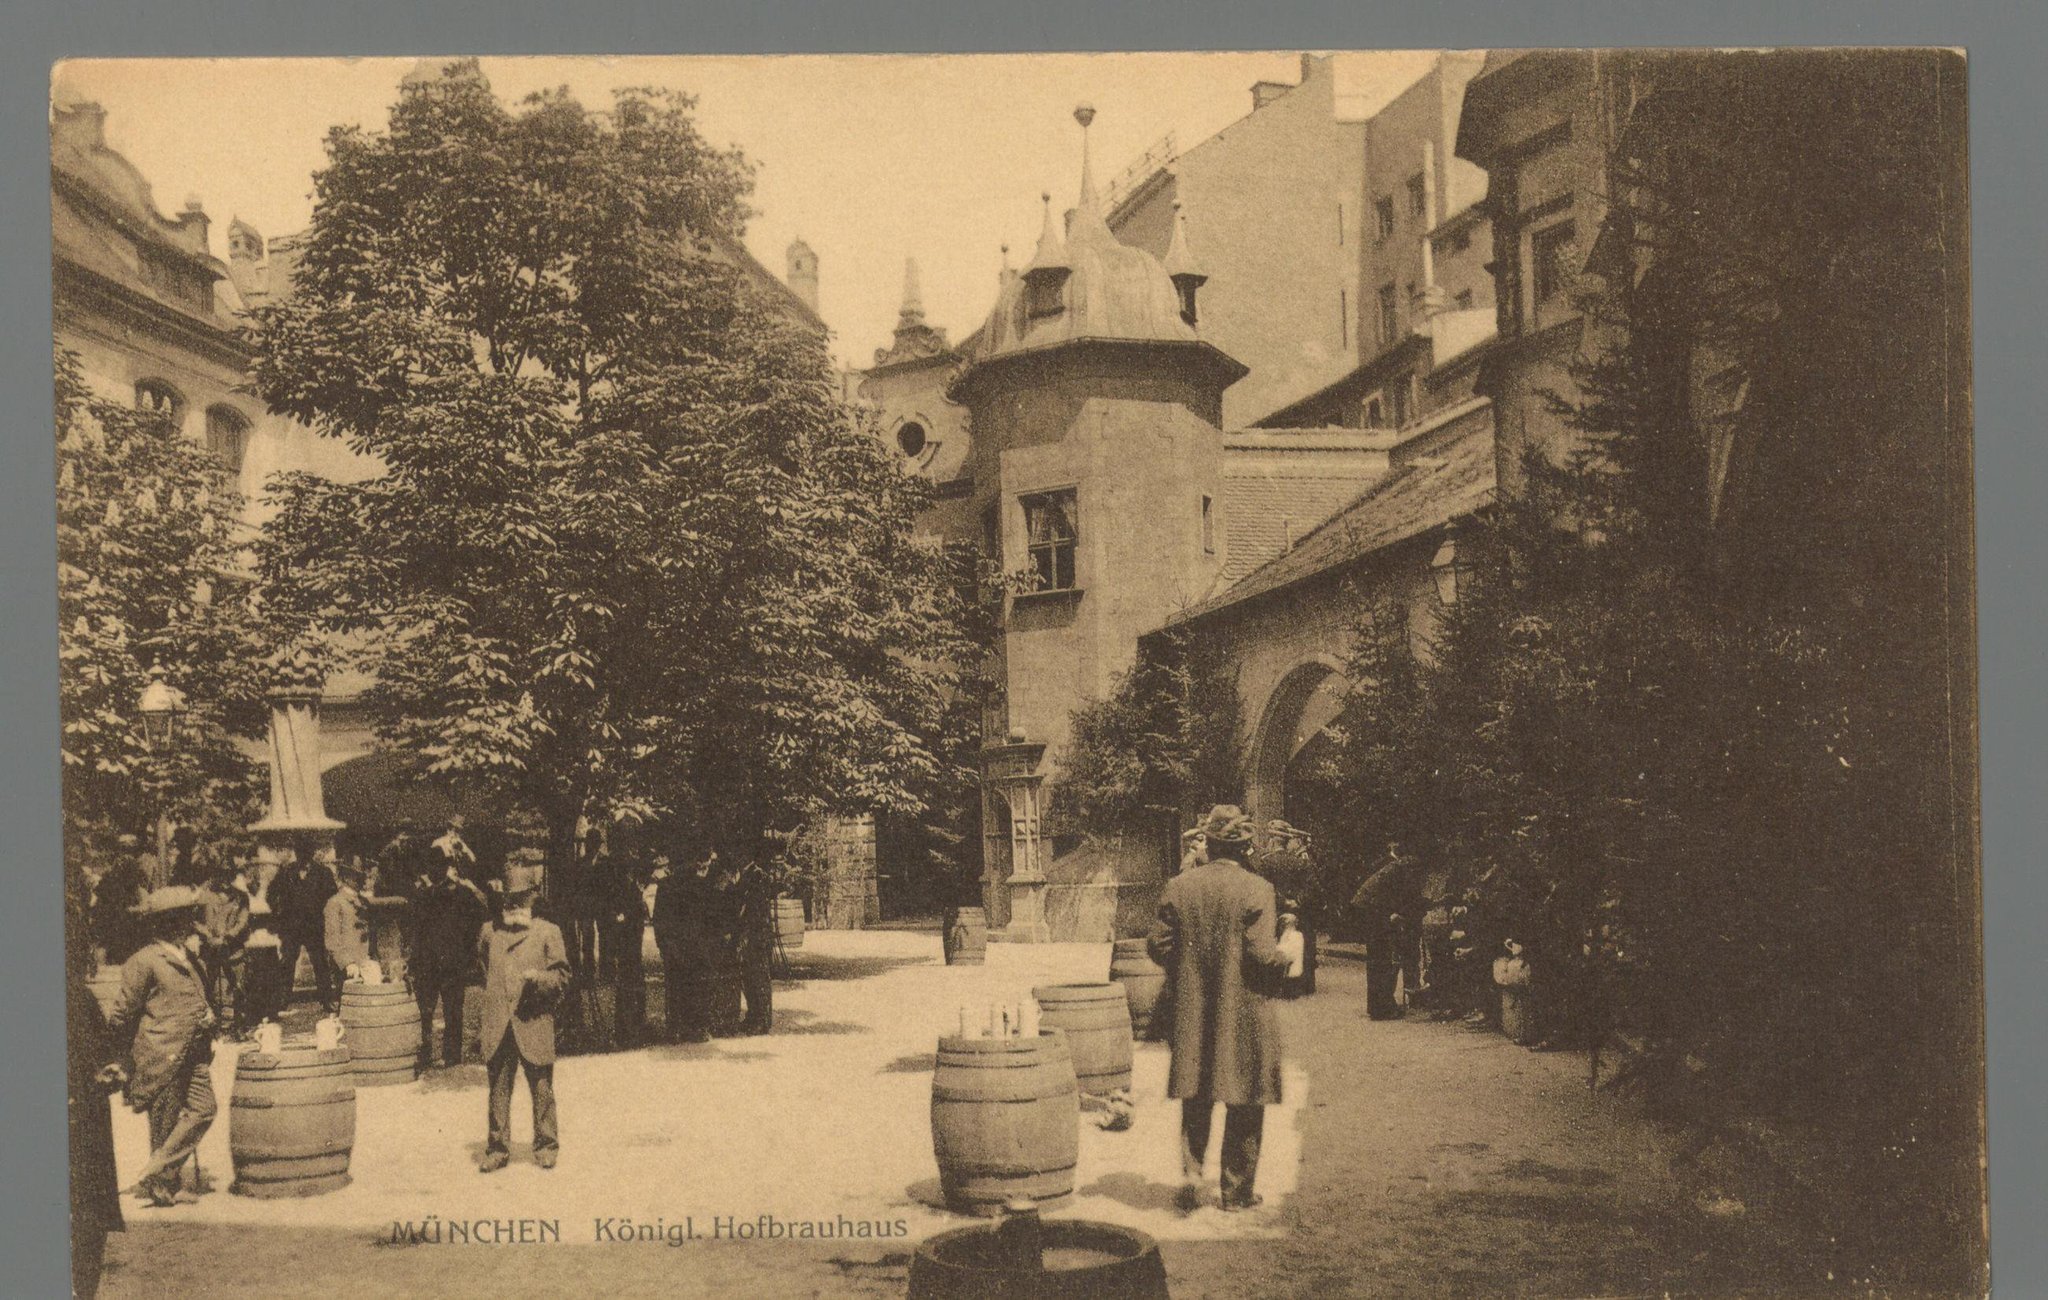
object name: ansichtkaart, prentbriefkaart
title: München. Königl. Hofbrauhaus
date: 1905-1930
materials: cardboard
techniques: photograph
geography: munich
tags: wooden container: barrel, cask, bucket, restaurant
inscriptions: inscription: ‘W.H.D.’